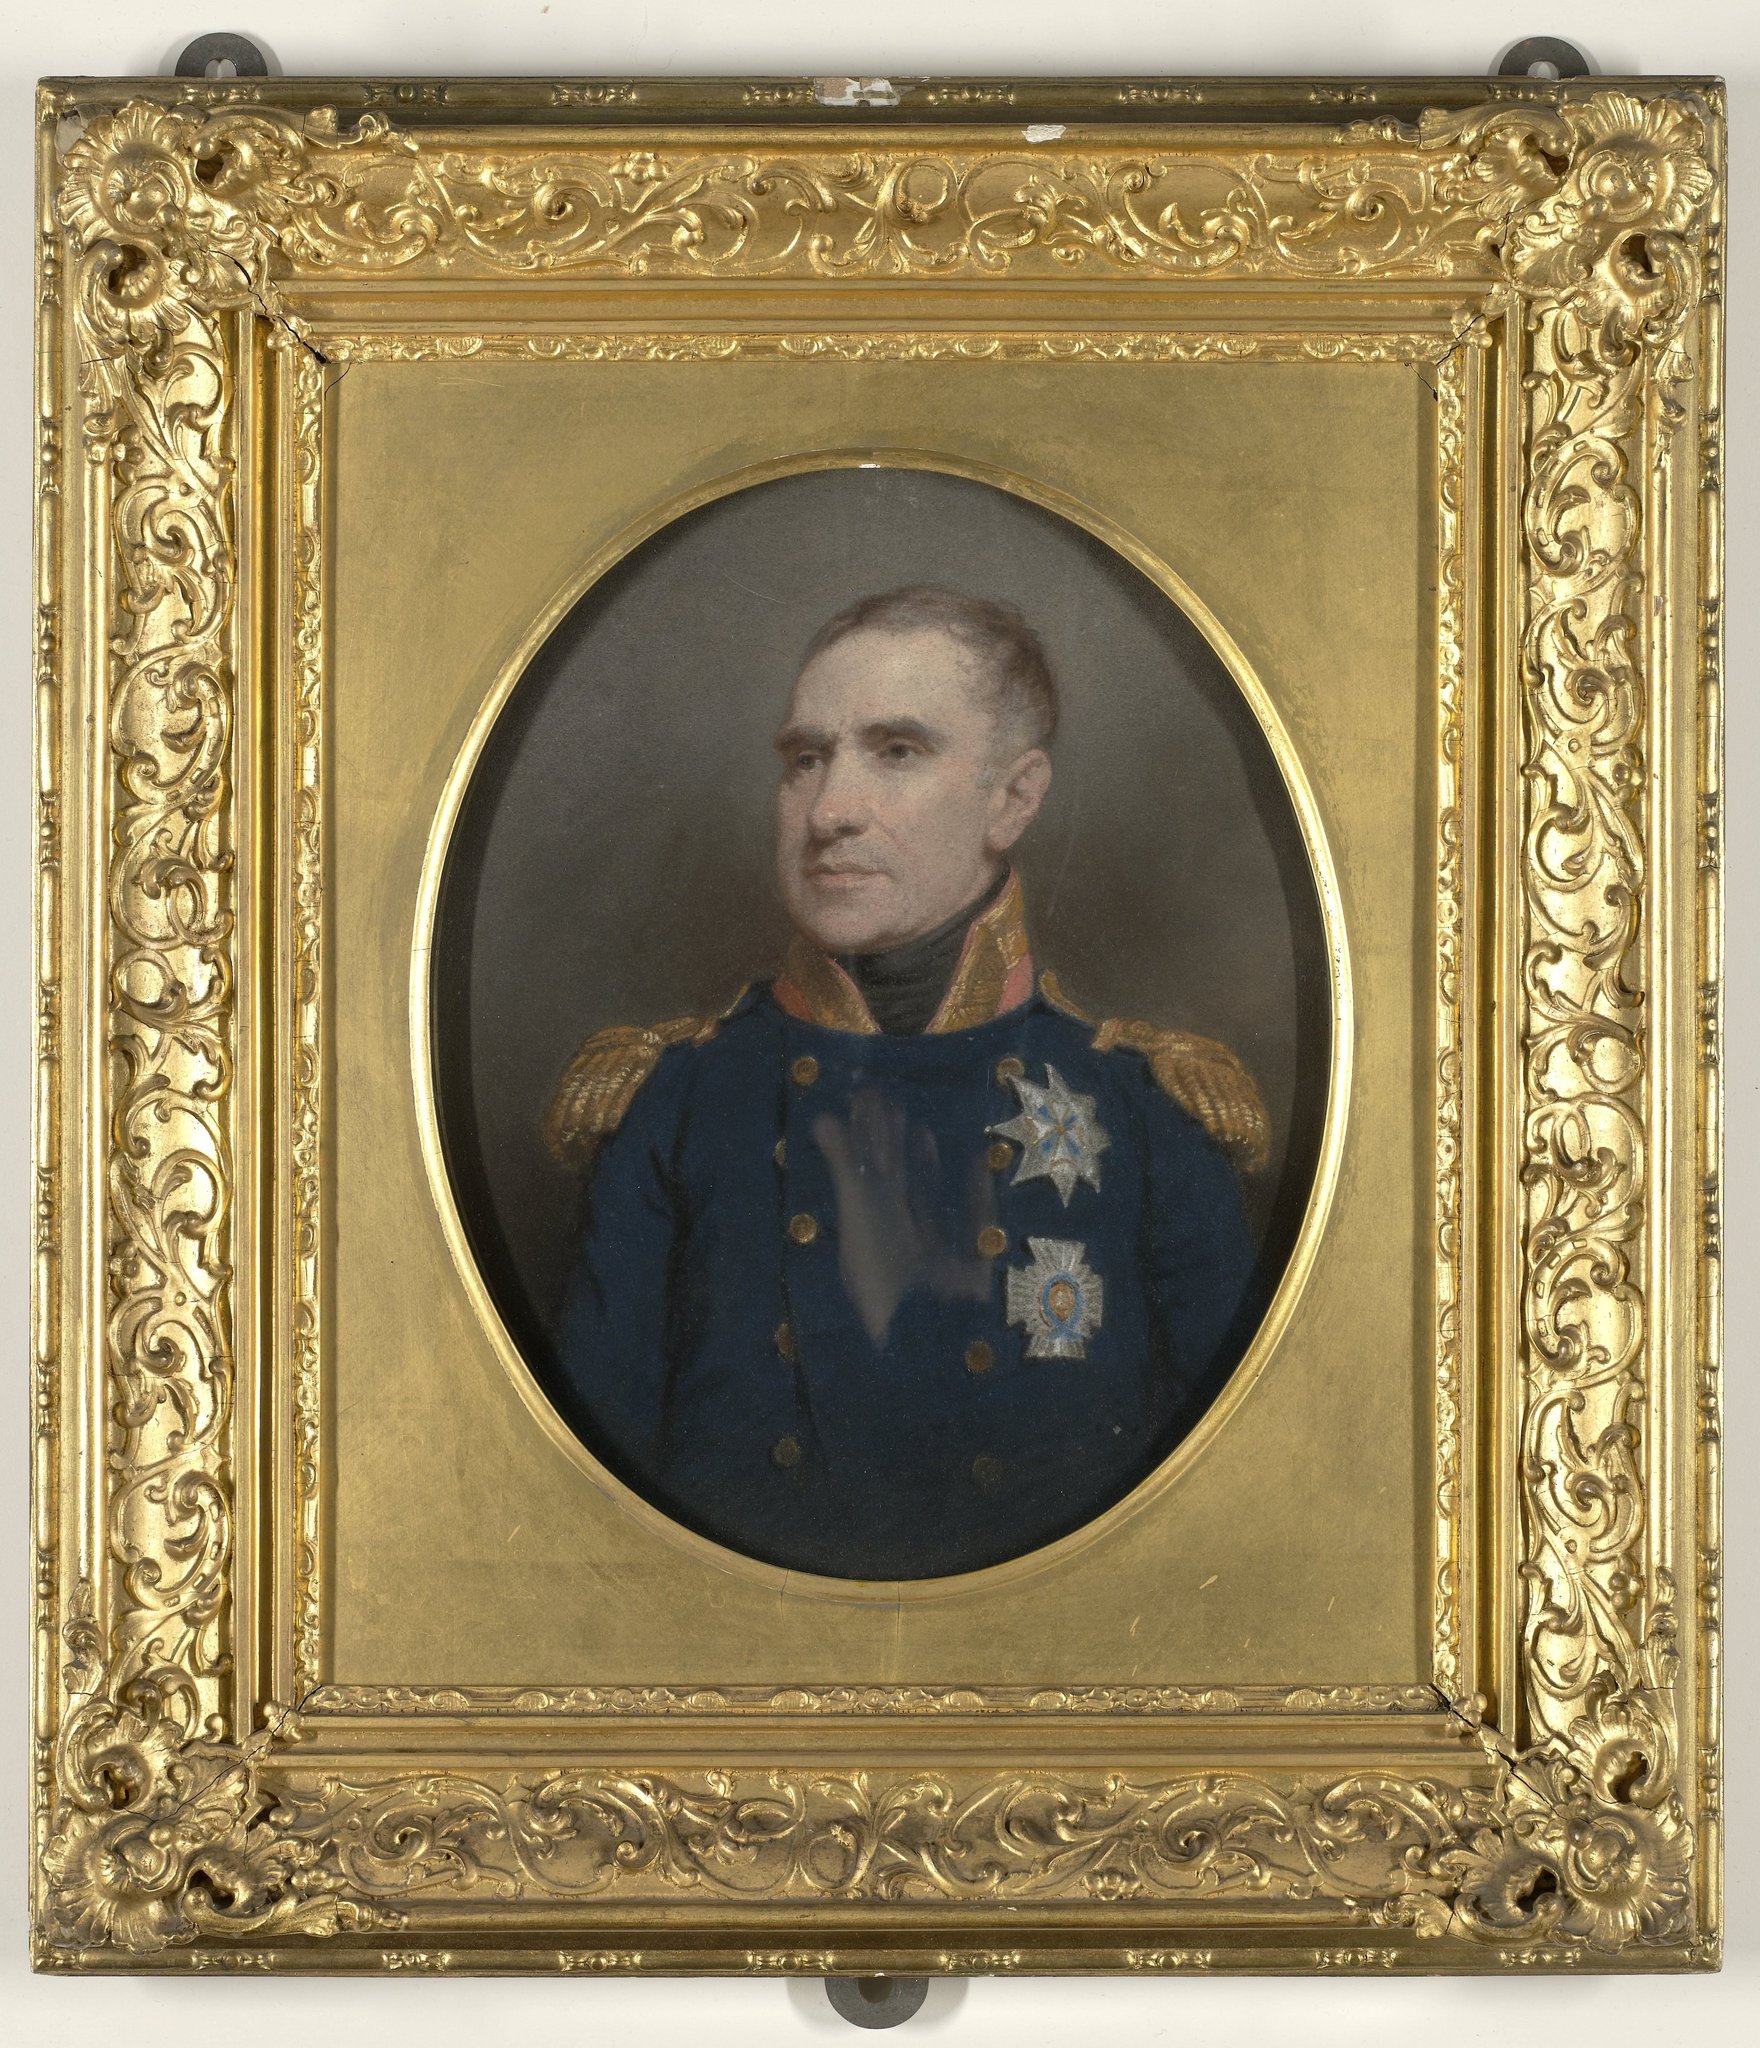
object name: drawing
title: Jonkheer Theodorus Frederik van Capellen (1761-1824), vice-admiraal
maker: charles howard hodges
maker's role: draughtsman, painter, print maker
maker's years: 1764-1837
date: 1800-1824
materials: parchment, pastel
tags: vice-admiraal, theodorus frederik van capellen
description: Portret van Jonkheer Theodorus Frederik van Capellen (1761-1824). Vice-admiraal. Buste in ovaal, naar links, in uniform met de decoratie van de Bath orde. Onderdeel van de collectie pastels.